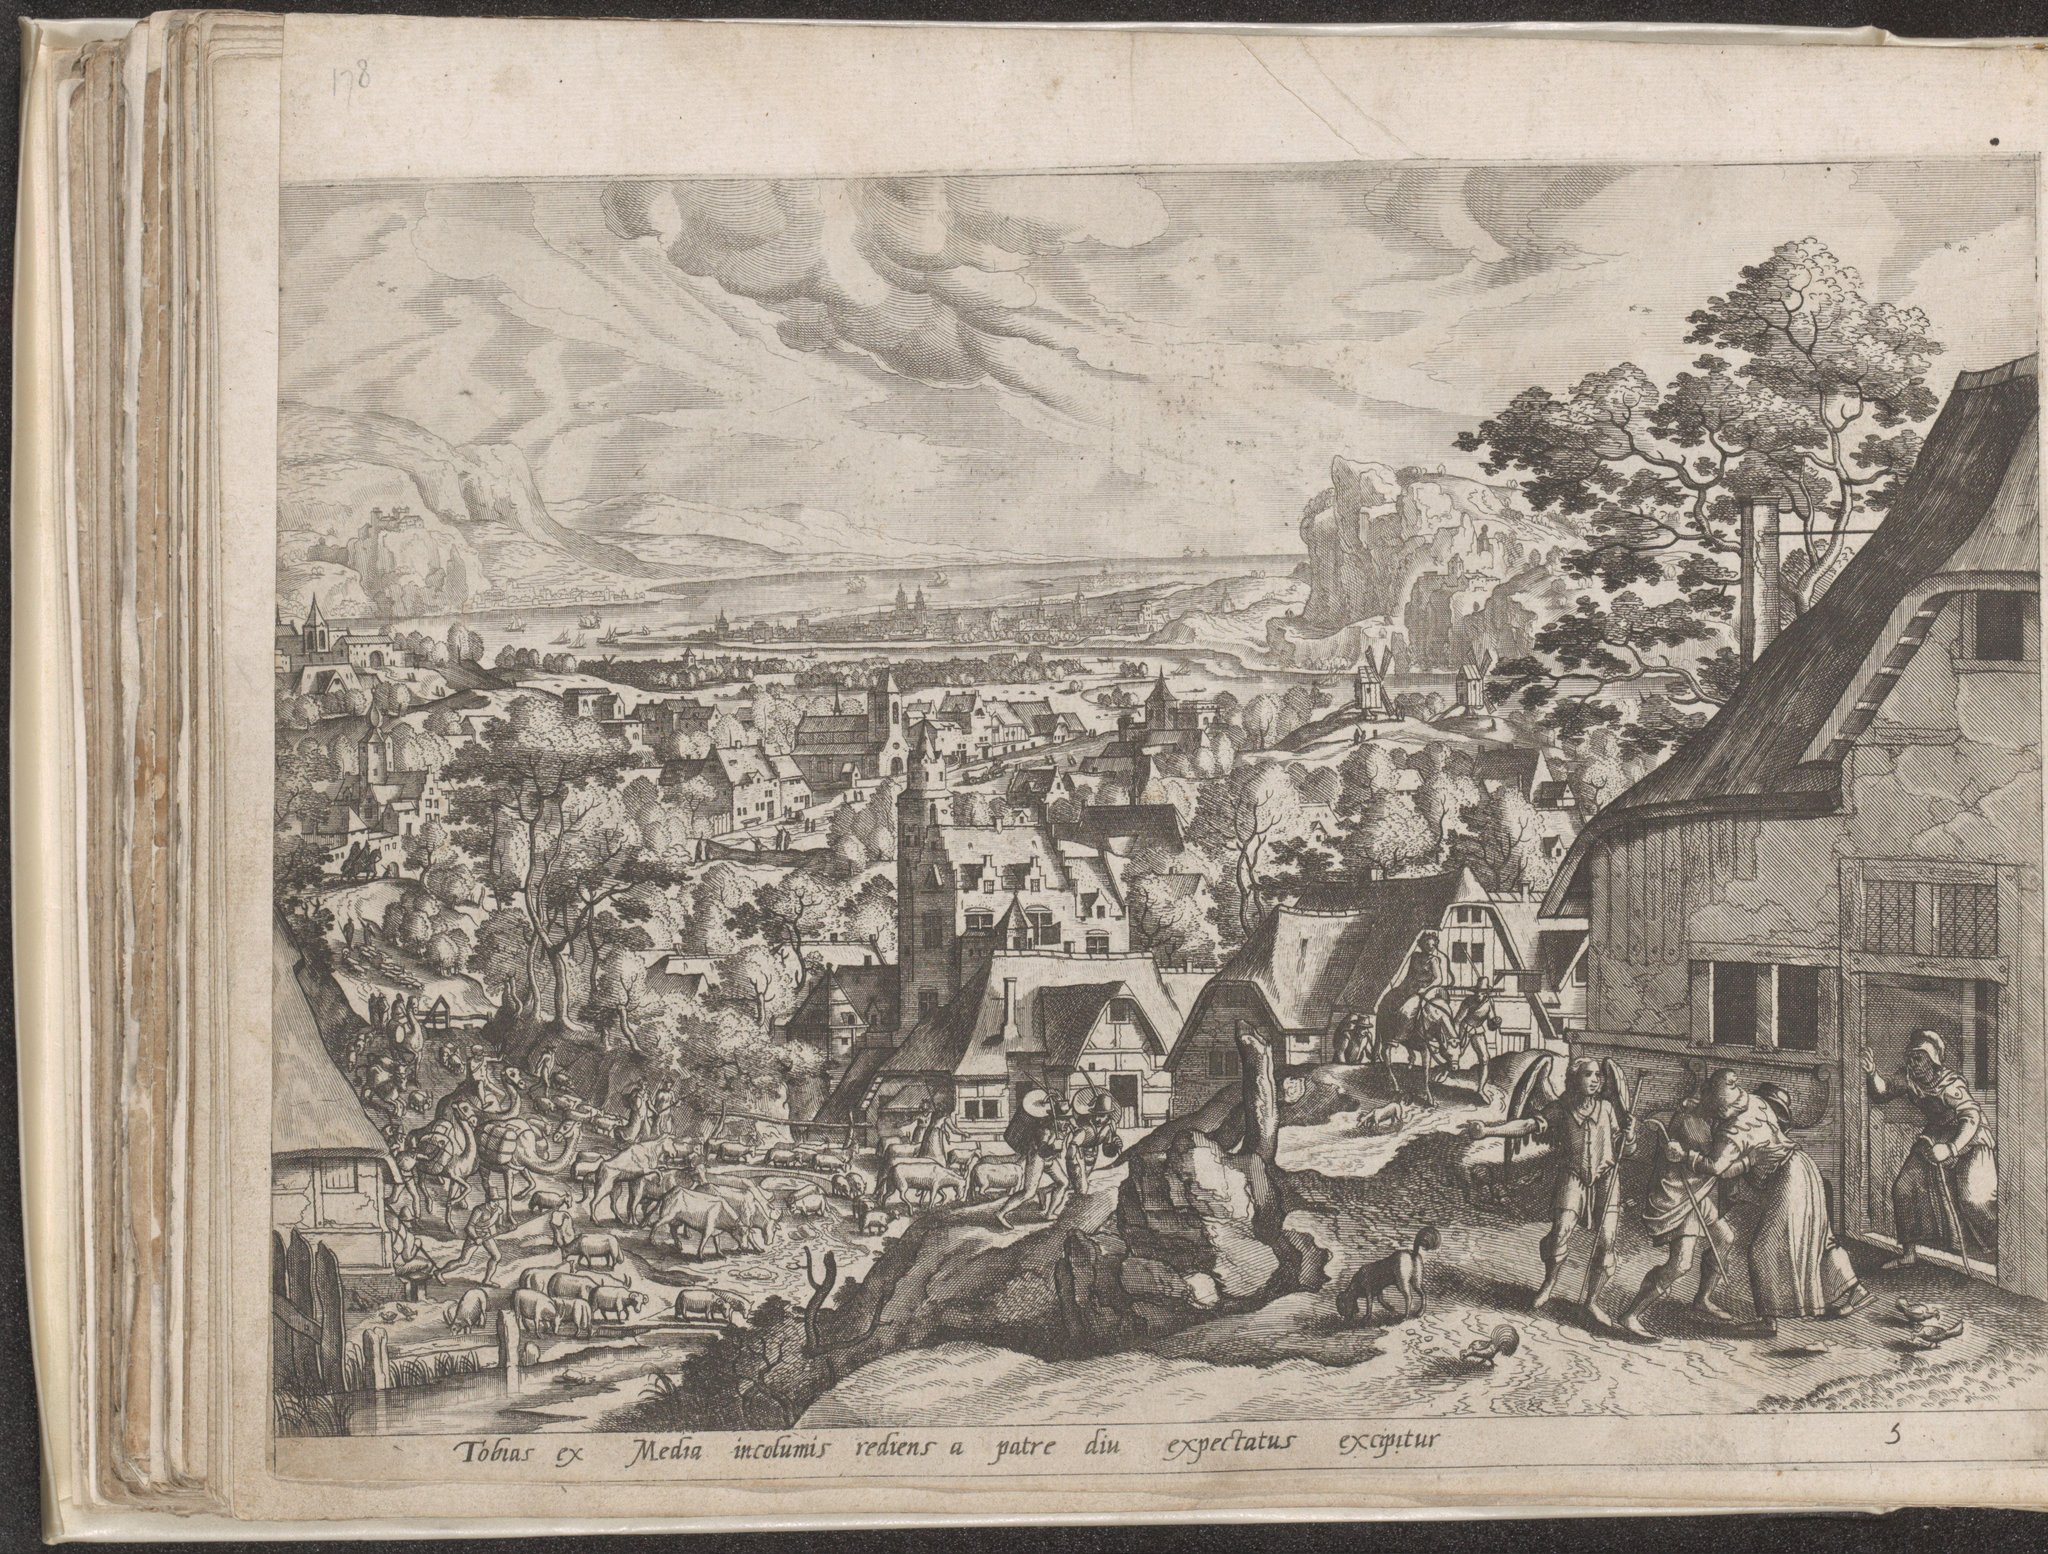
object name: album leaf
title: Geschiedenis van Tobias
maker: johannes of lucas van doetechum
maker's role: print maker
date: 1563-1567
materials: paper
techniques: engraving, etching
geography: antwerp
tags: sarah's arrival ~ tobias' return, river, story of tobias: tobias' return (tobit 10-13), the meeting of parents and son ~ tobias' return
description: Landschap met rechts op de voorgrond de terugkeer van Tobias en de engel. Tobit valt zijn zoon om de hals, in de deuropening komt Anna aangesneld. Iets verder op de achtergrond zit Tobias'vrouw Sara op de rug van een ezel. Links arriveren de dienaren en het vee, die Tobias heeft gekregen van zijn schoonvader Raguel. Onder de voorstelling een verklarende tekst in het Latijn. Deze prent maakt deel uit van een album.